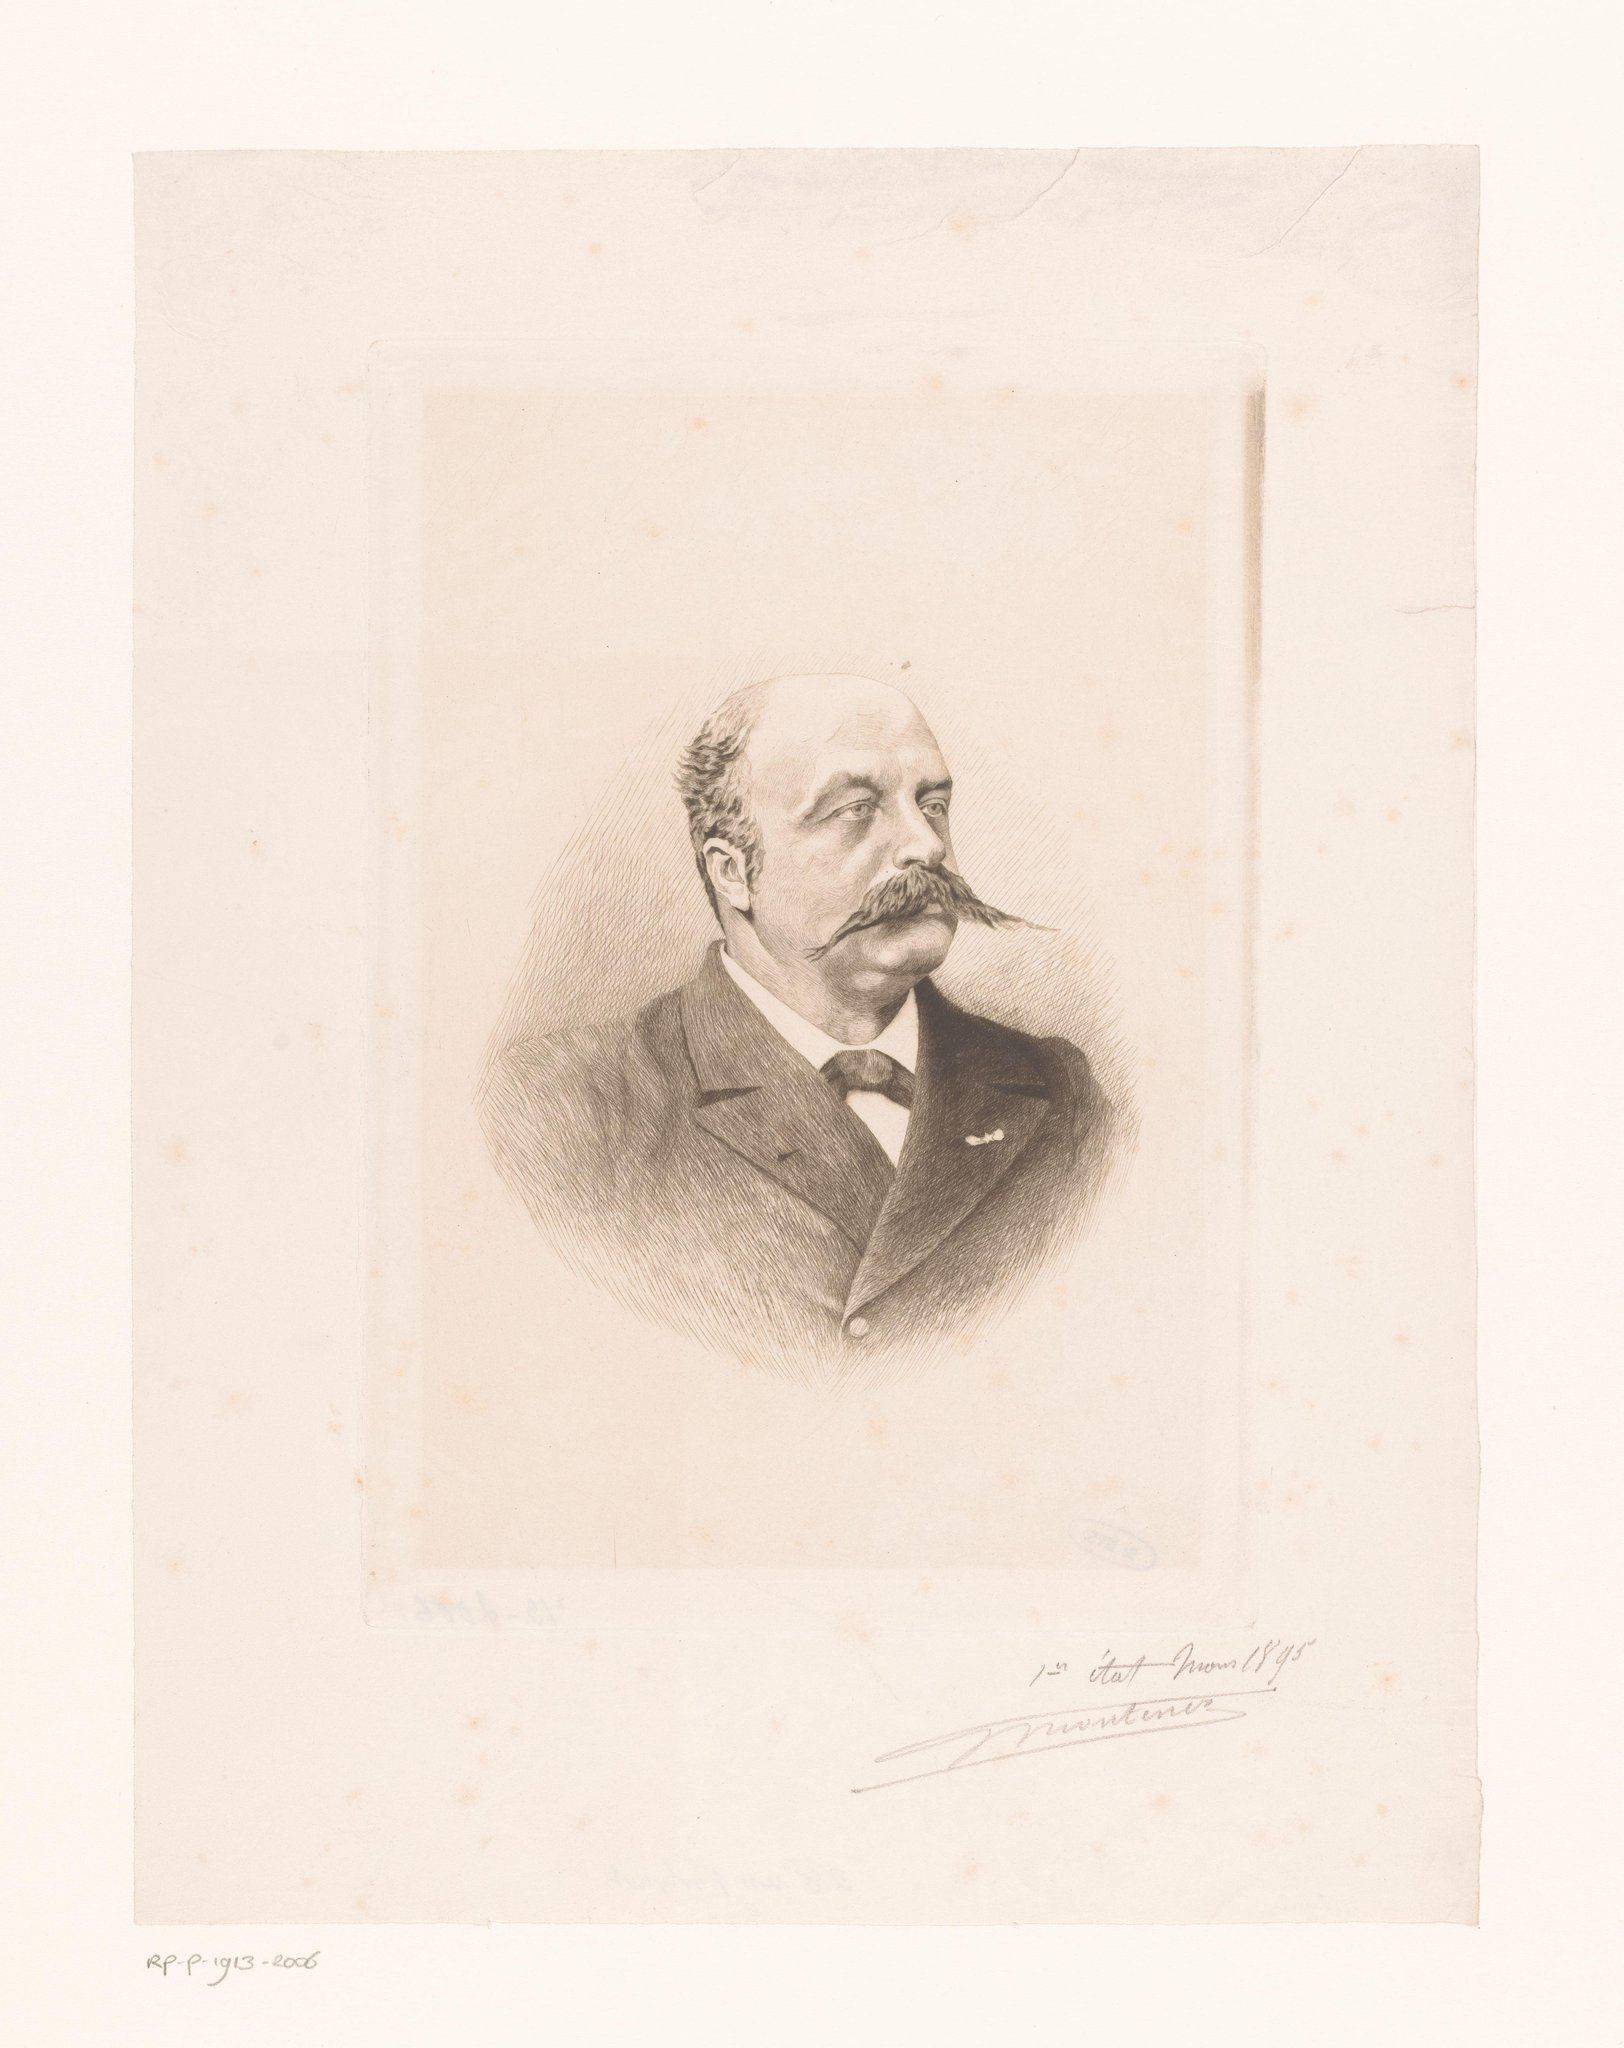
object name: print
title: Portret van een onbekende man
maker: georges montenez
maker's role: print maker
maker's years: 1873-1930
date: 1895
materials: paper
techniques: etching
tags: moustache, adult man, historical persons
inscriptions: inscription: ‘1e état Mons 1895’, collector's mark: Lugt 2228